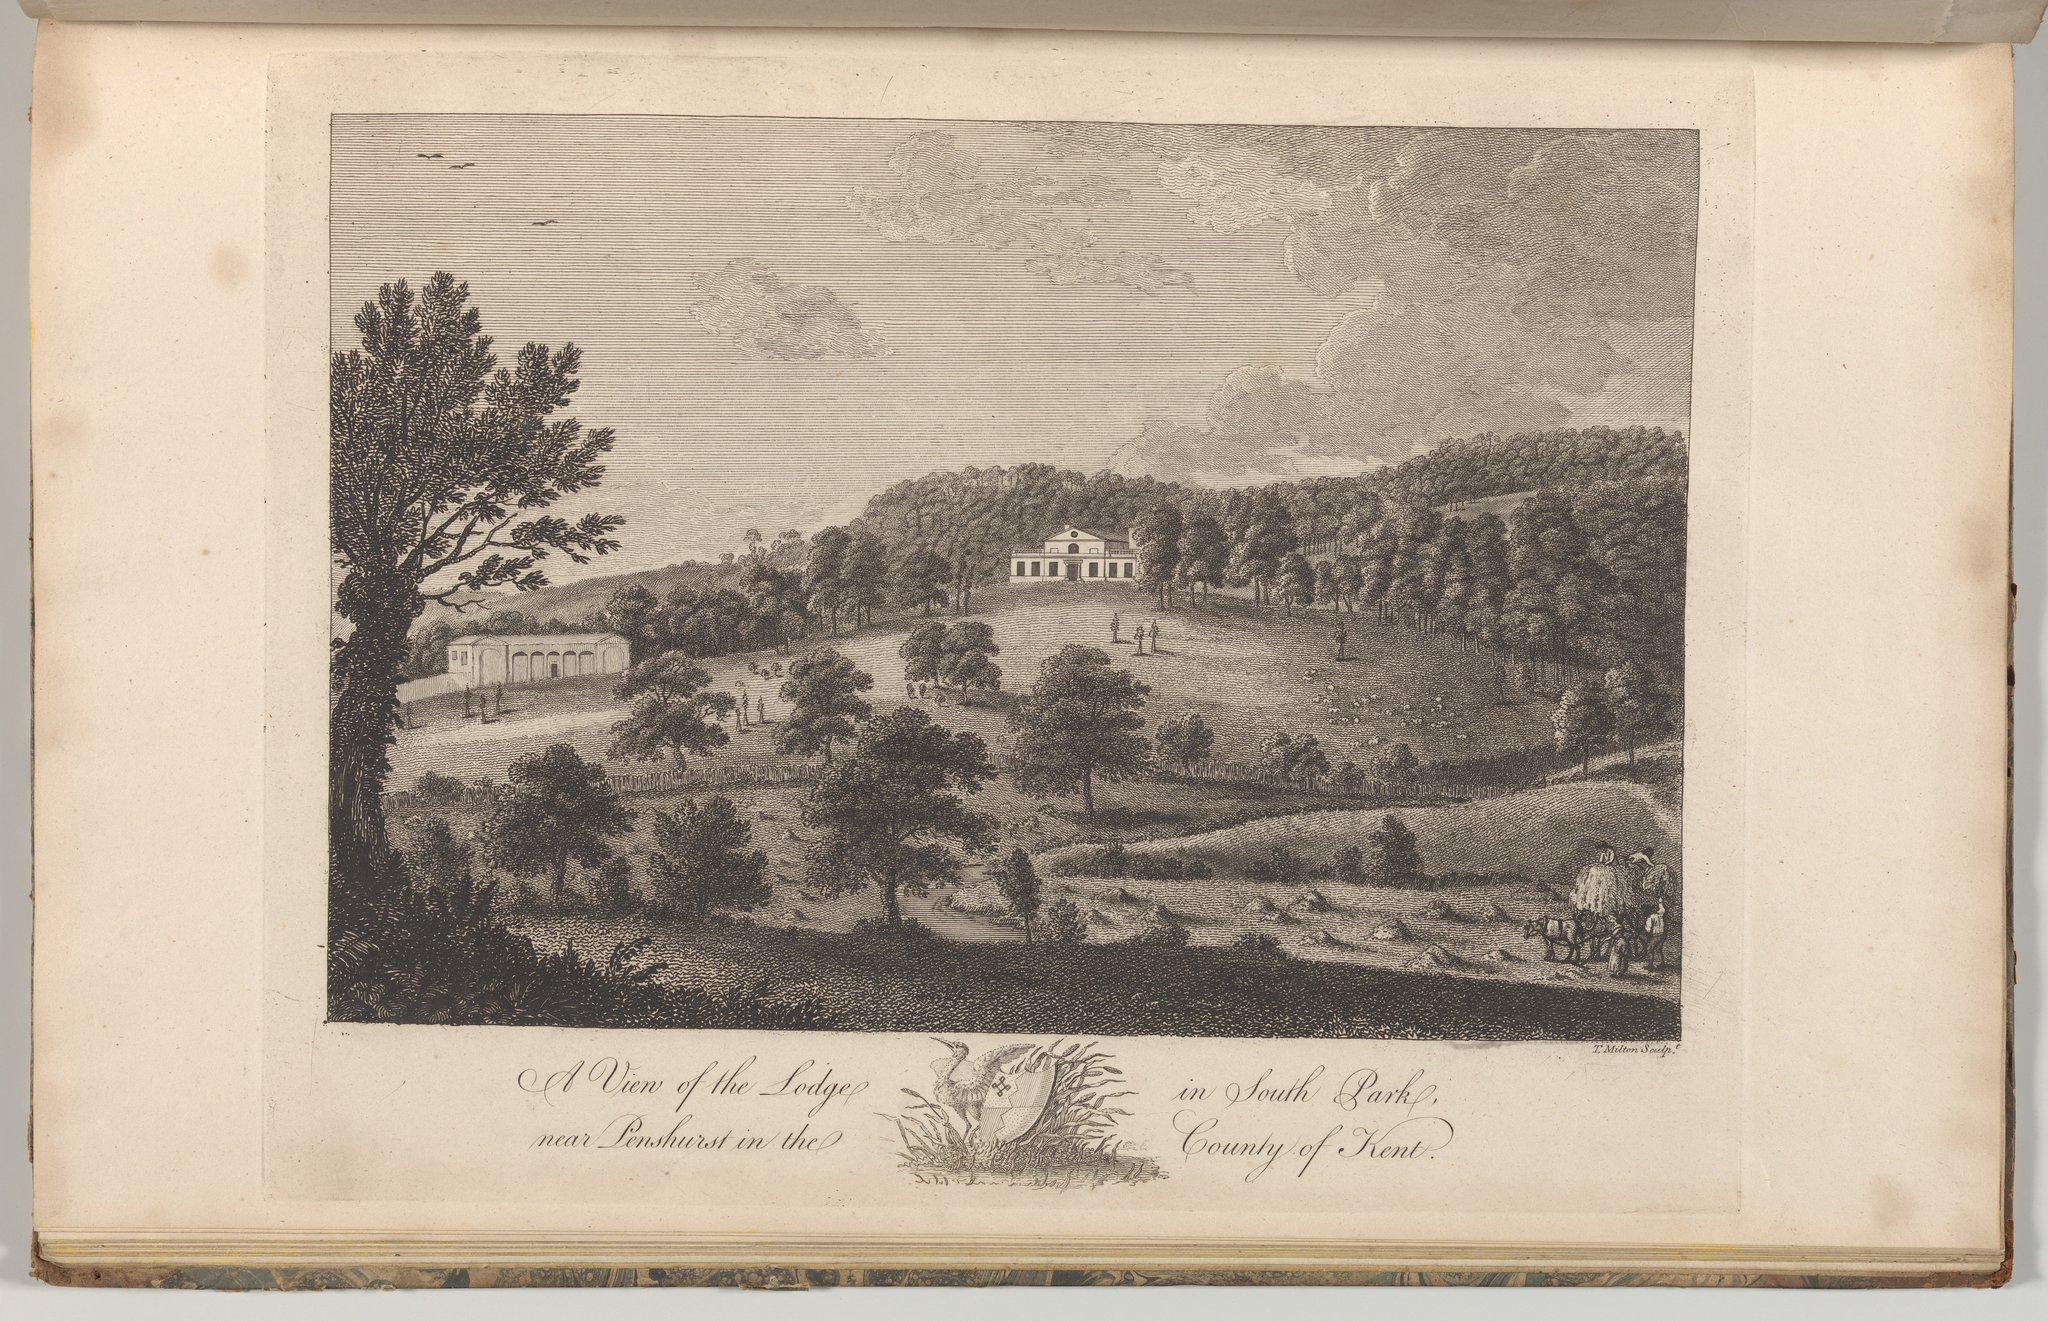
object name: print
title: A View of the Lodge in the South Park, near Penshurst in the County of Kent, from Edward Hasted's "The History and Topographical Survey of the County of Kent", vols. 1-3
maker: thomas milton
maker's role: artist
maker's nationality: british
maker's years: 1743-1827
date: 1777-1790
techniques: engraving, etching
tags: buildings,parks,landscapes,trees